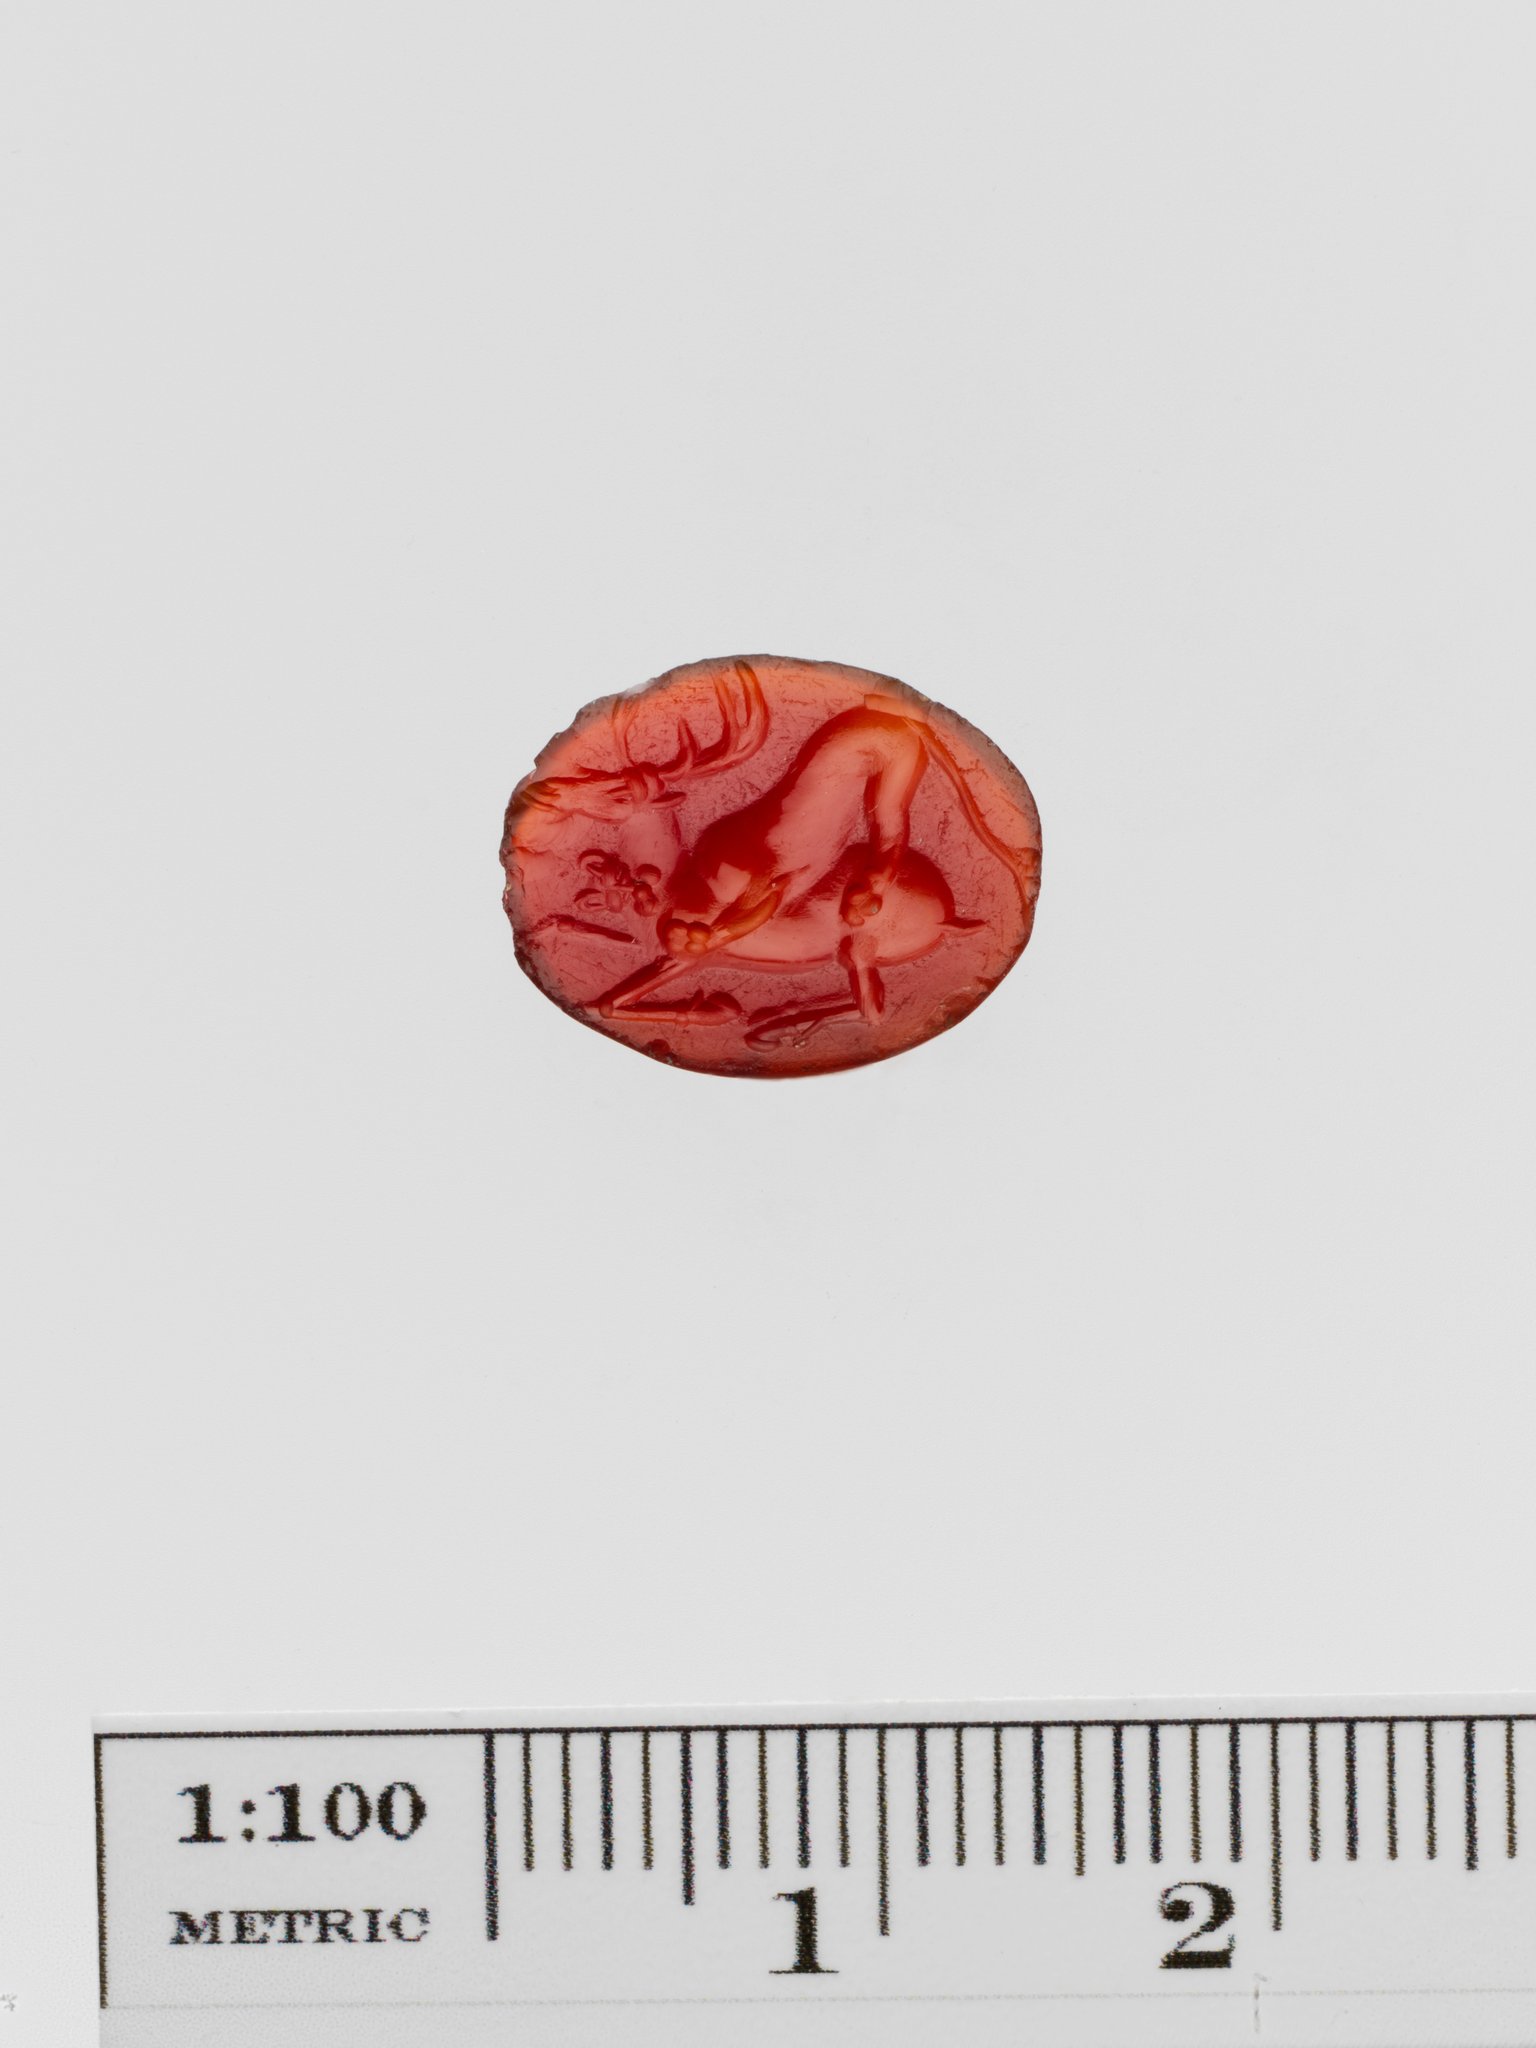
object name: intaglio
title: Carnelian ring stone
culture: greek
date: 400-301 BCE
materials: gemstone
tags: hunting,deer,lions